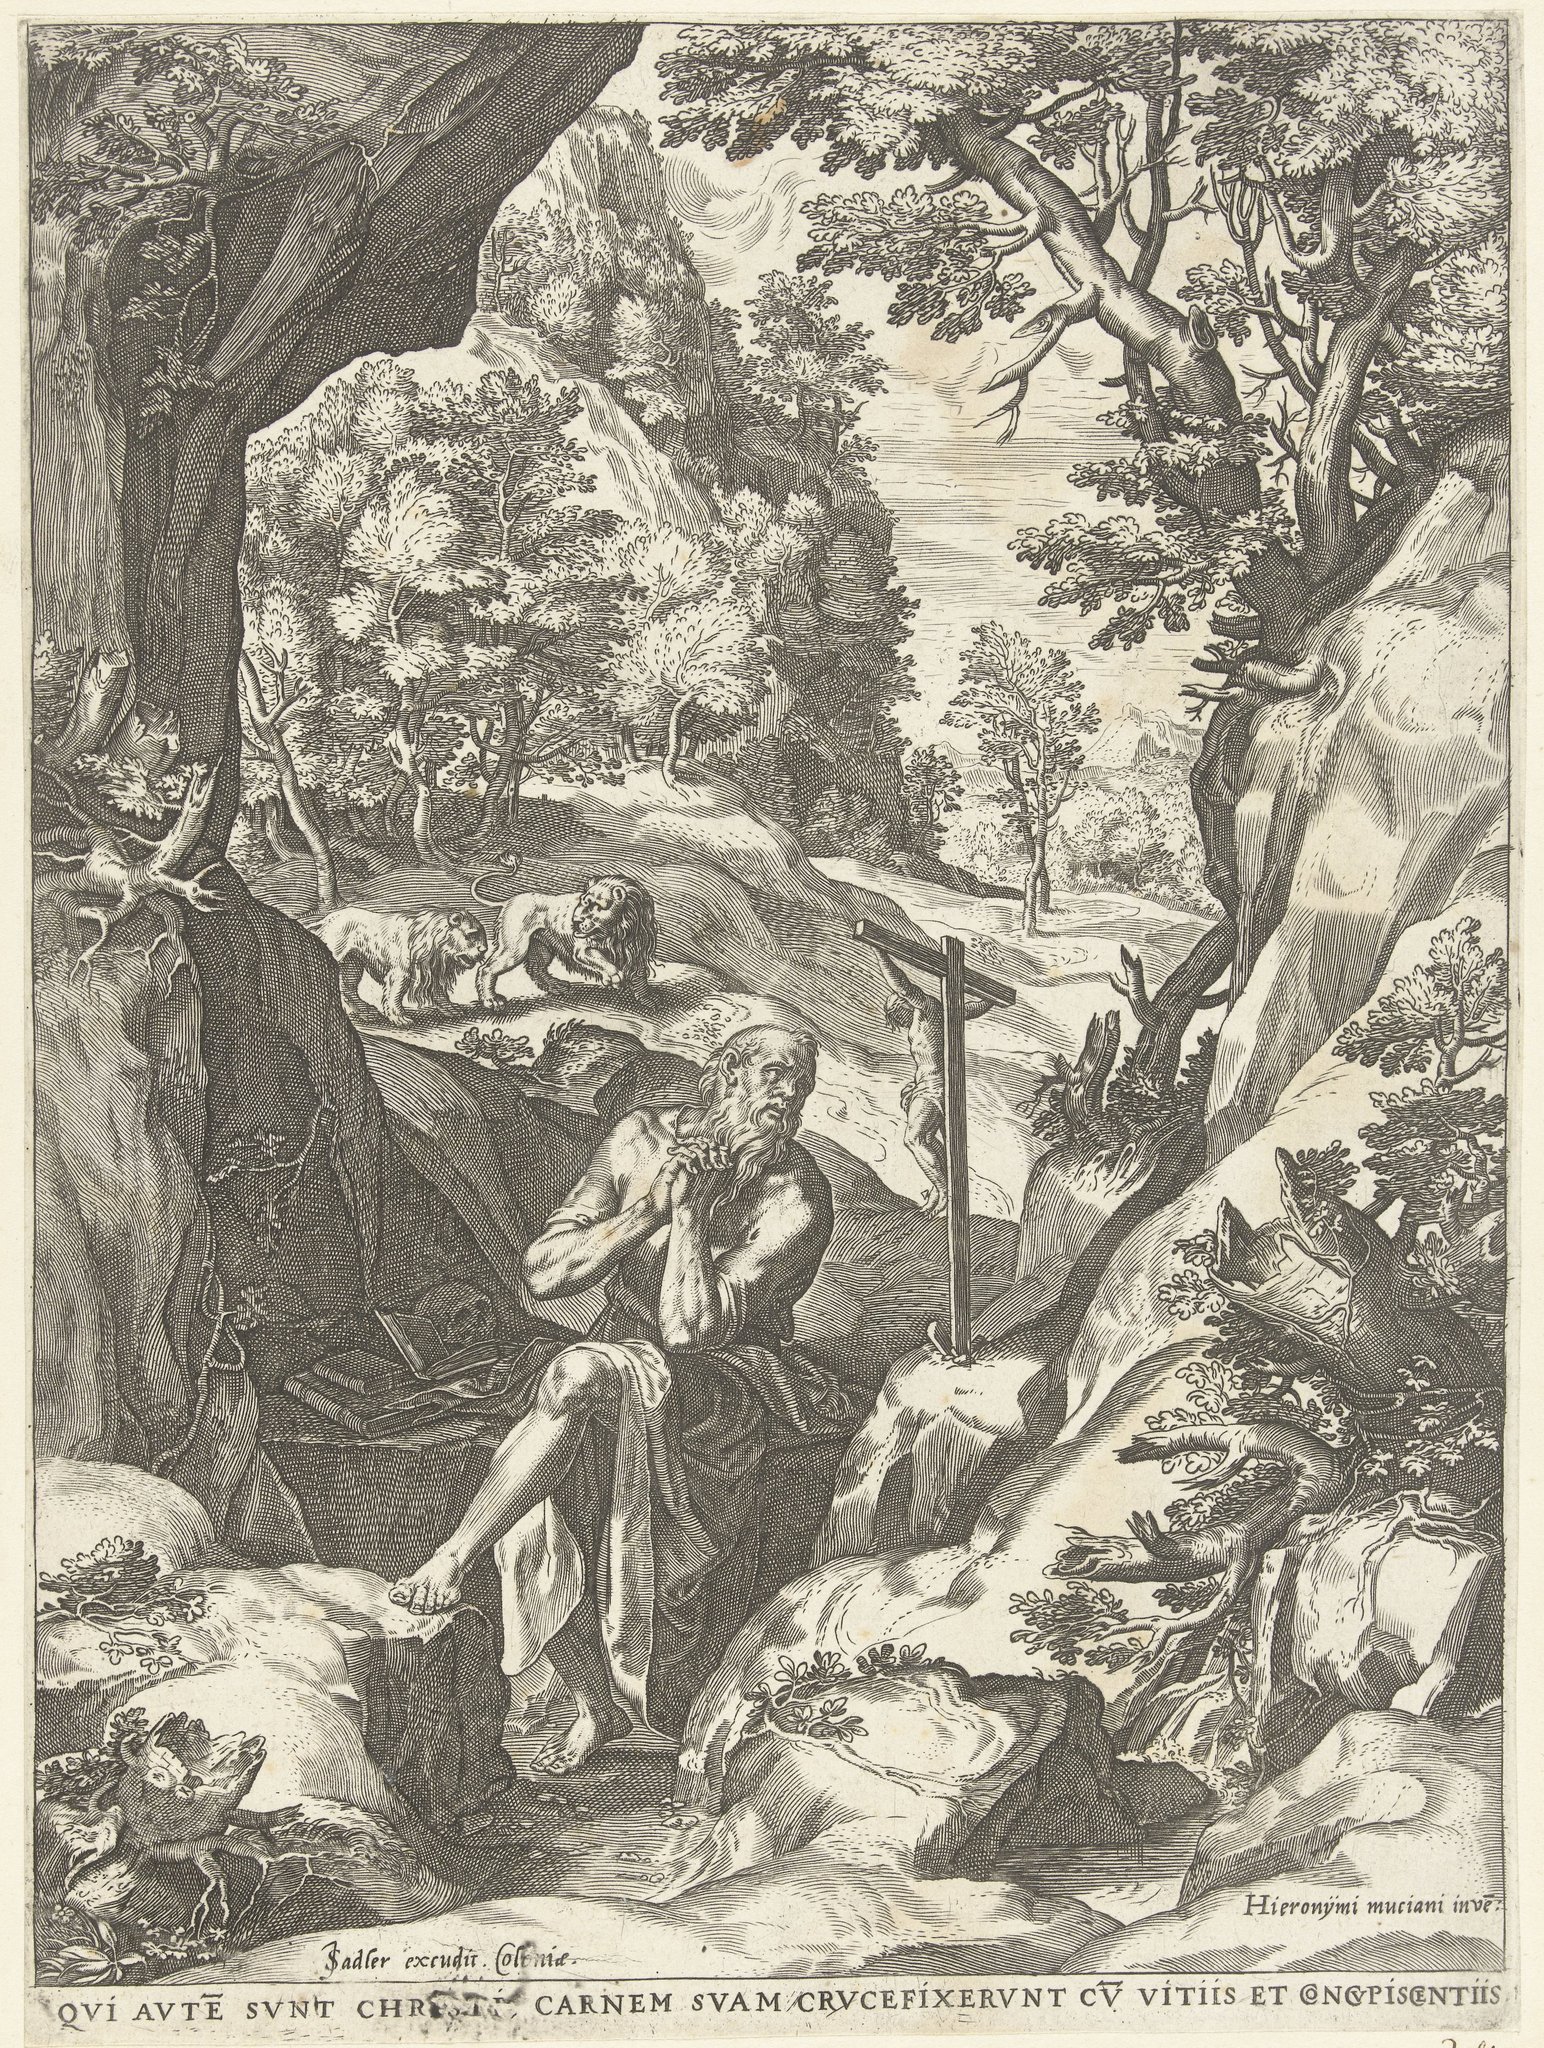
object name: print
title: Landschap met de H. Hieronymus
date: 1579-1586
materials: paper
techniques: engraving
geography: rome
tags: martyrdom, suffering, misfortune, death of st. jerome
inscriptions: collector's mark: Lugt 240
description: Hieronymus, biddend voor een crucifix in een landschap, naast hem boeken en een doodskop. Op de achtergrond twee leeuwen.